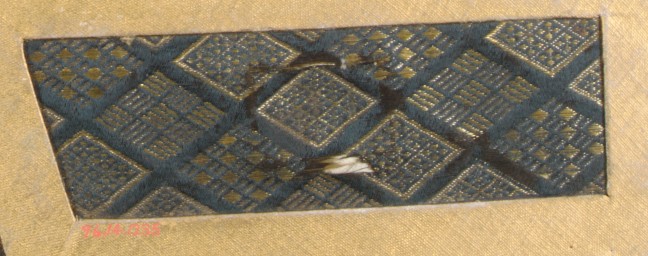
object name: piece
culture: japanese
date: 1701-1900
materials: silk